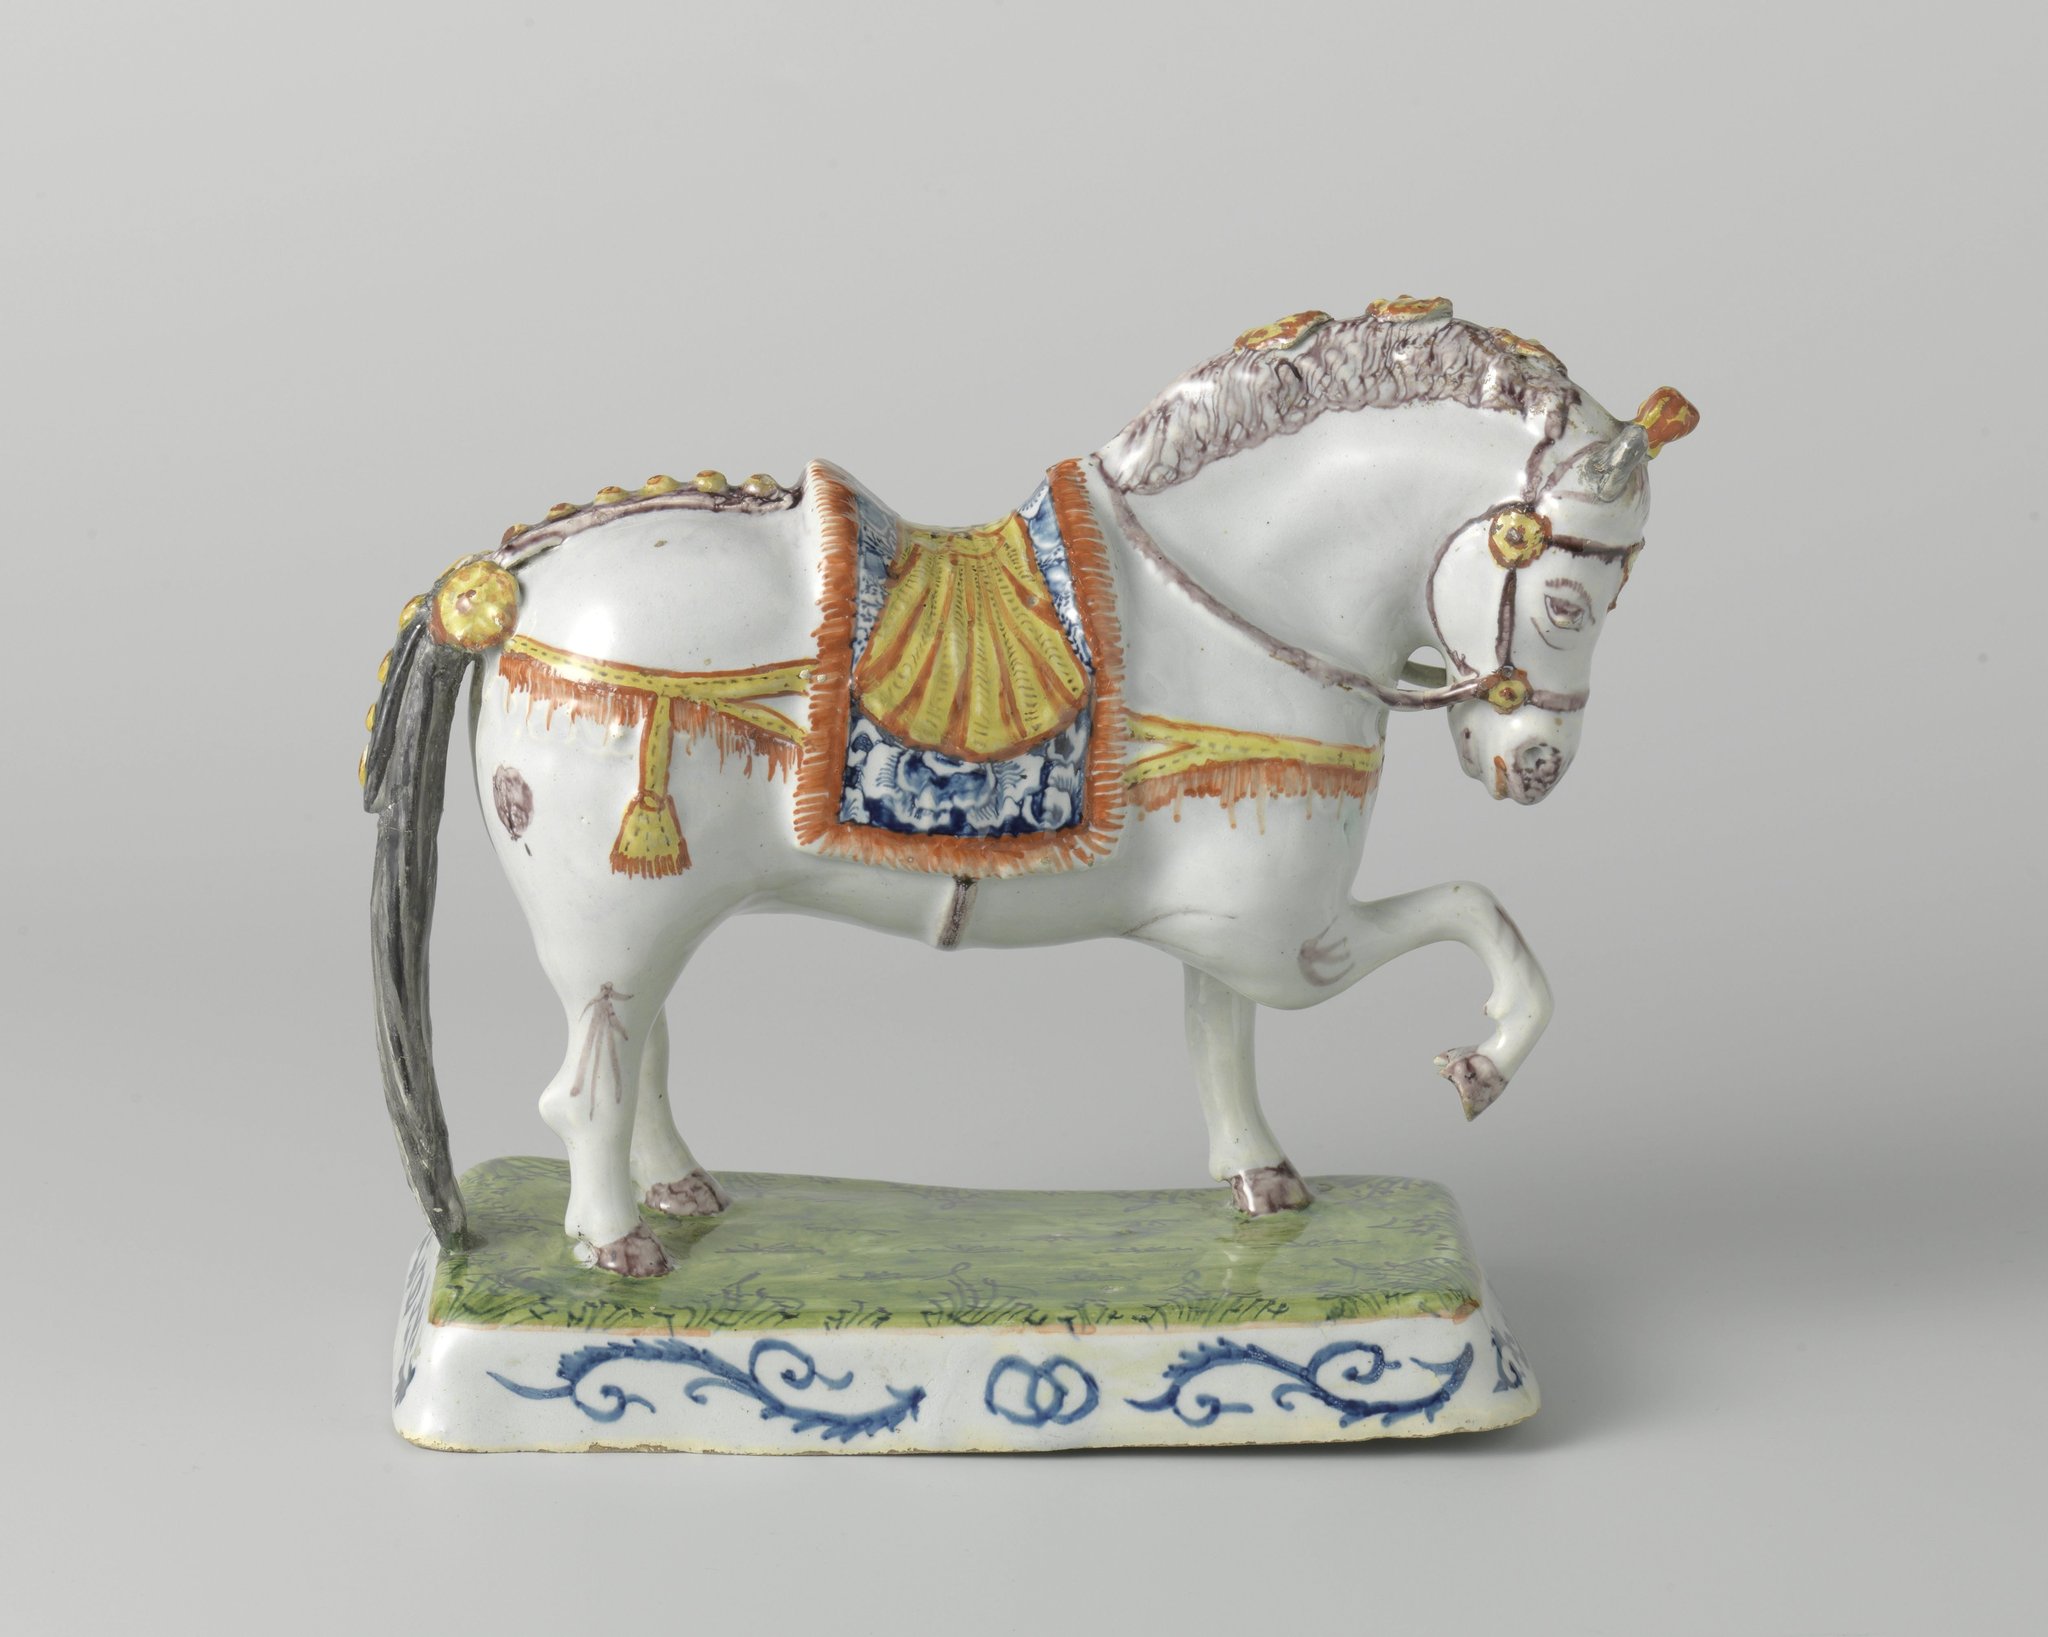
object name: decoratief object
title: Paard van faience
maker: Anonymous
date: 1760-1790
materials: faience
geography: delft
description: Dierenfiguur van faience, voorstellende een paard. Veelkleurig beschilderd.